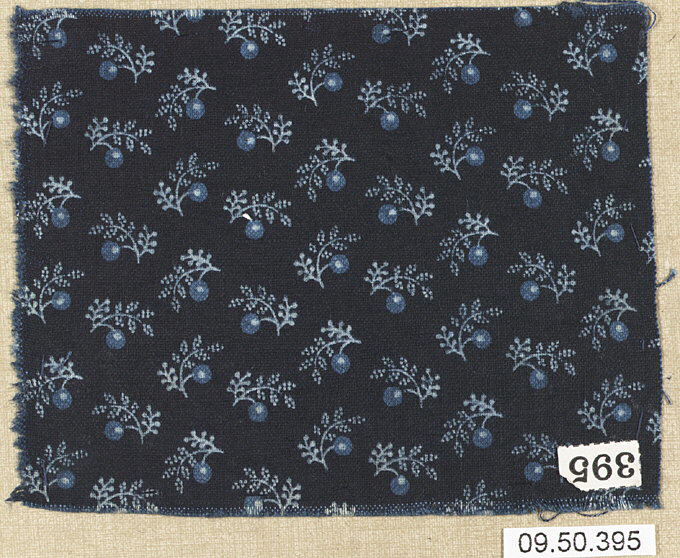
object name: piece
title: Piece (one of 116)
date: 1801-1900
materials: cotton